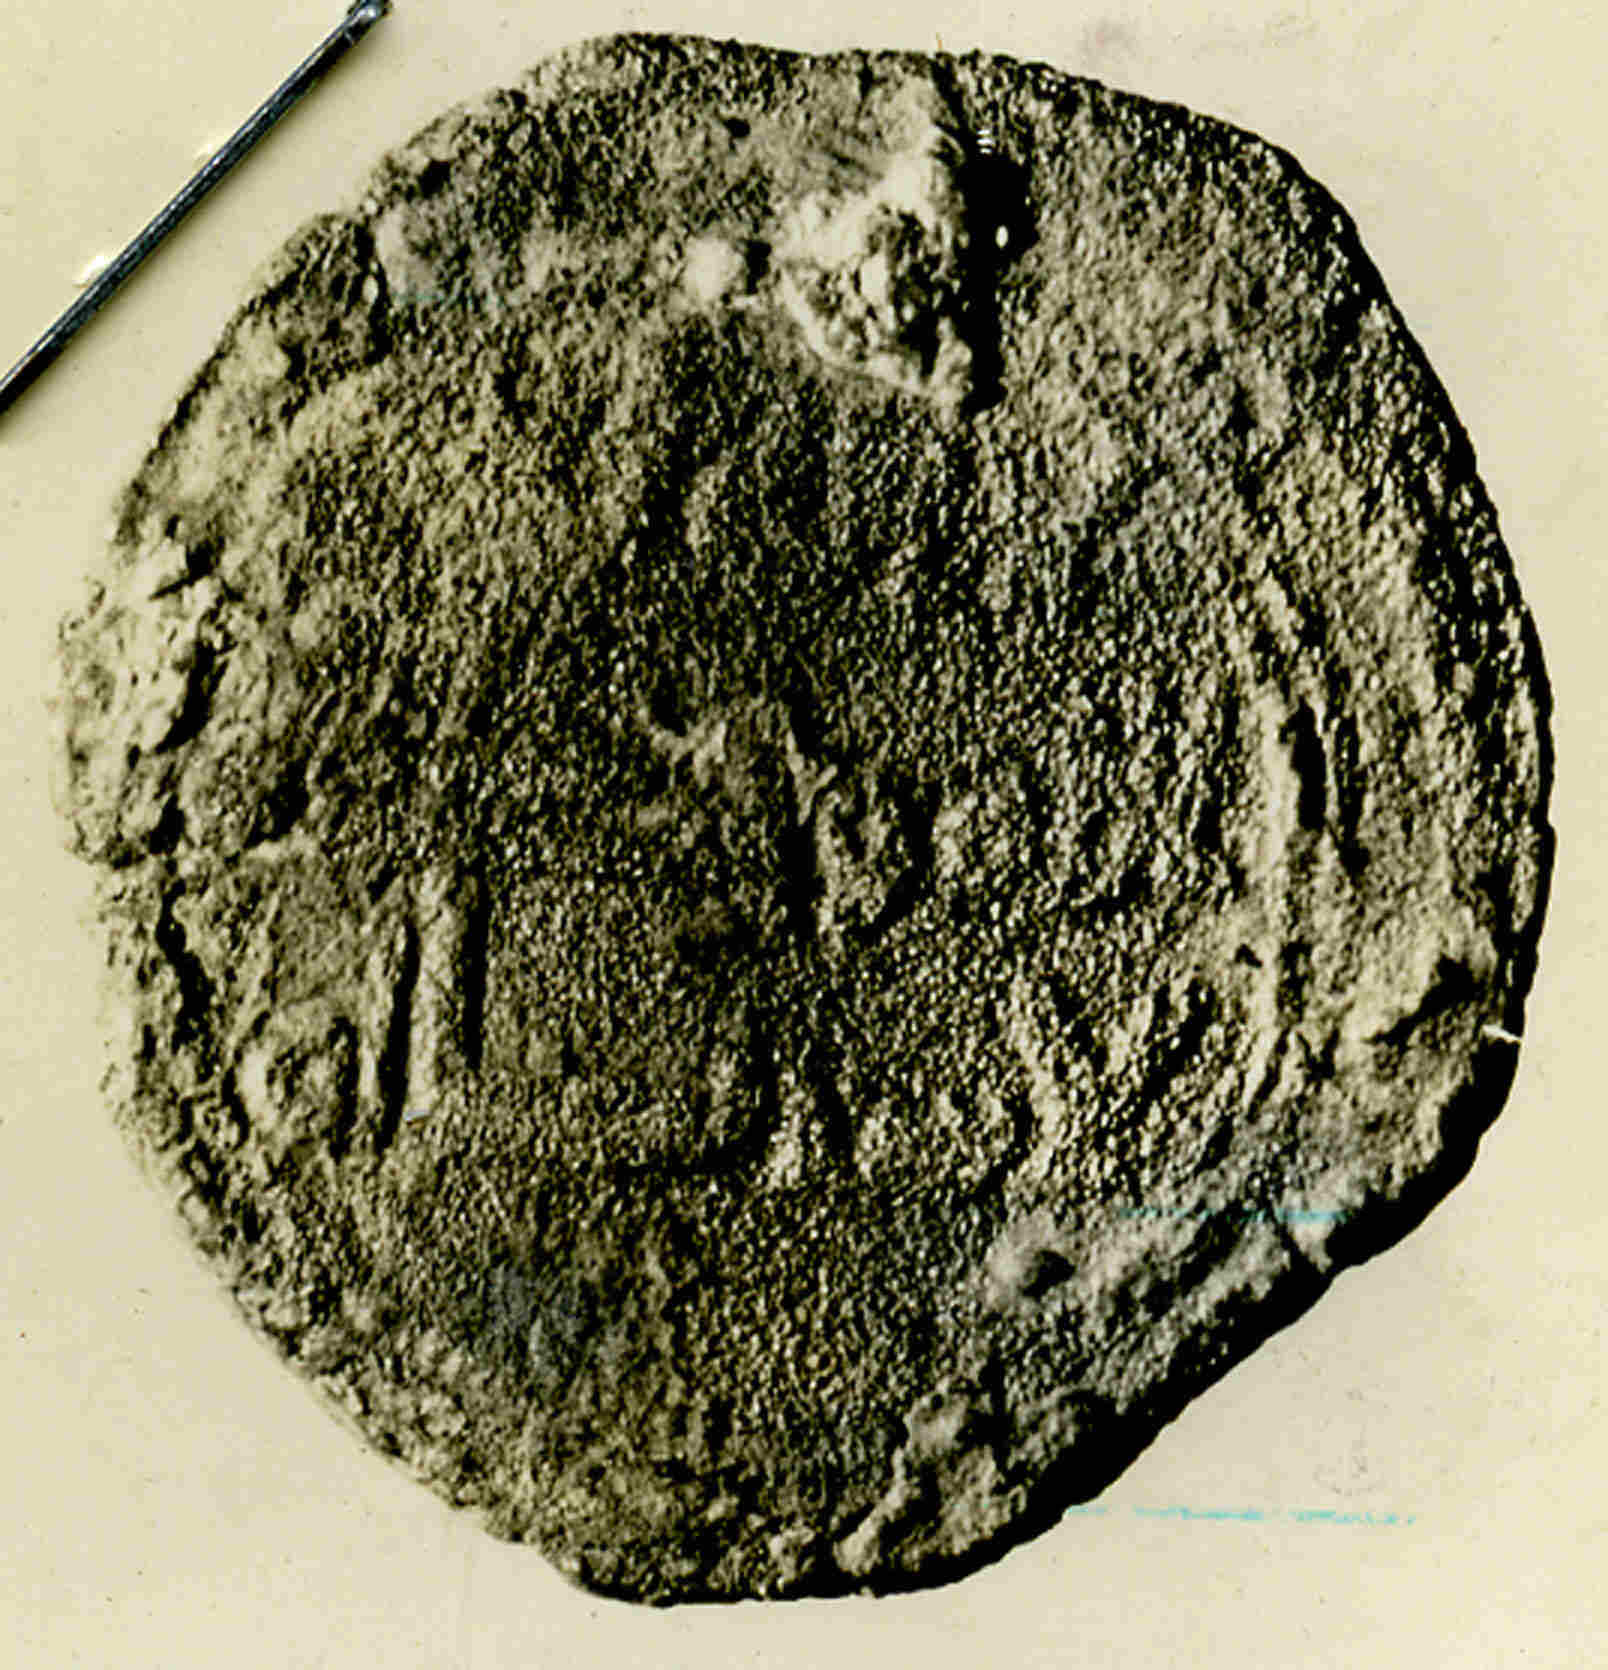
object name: coin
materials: copper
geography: iran